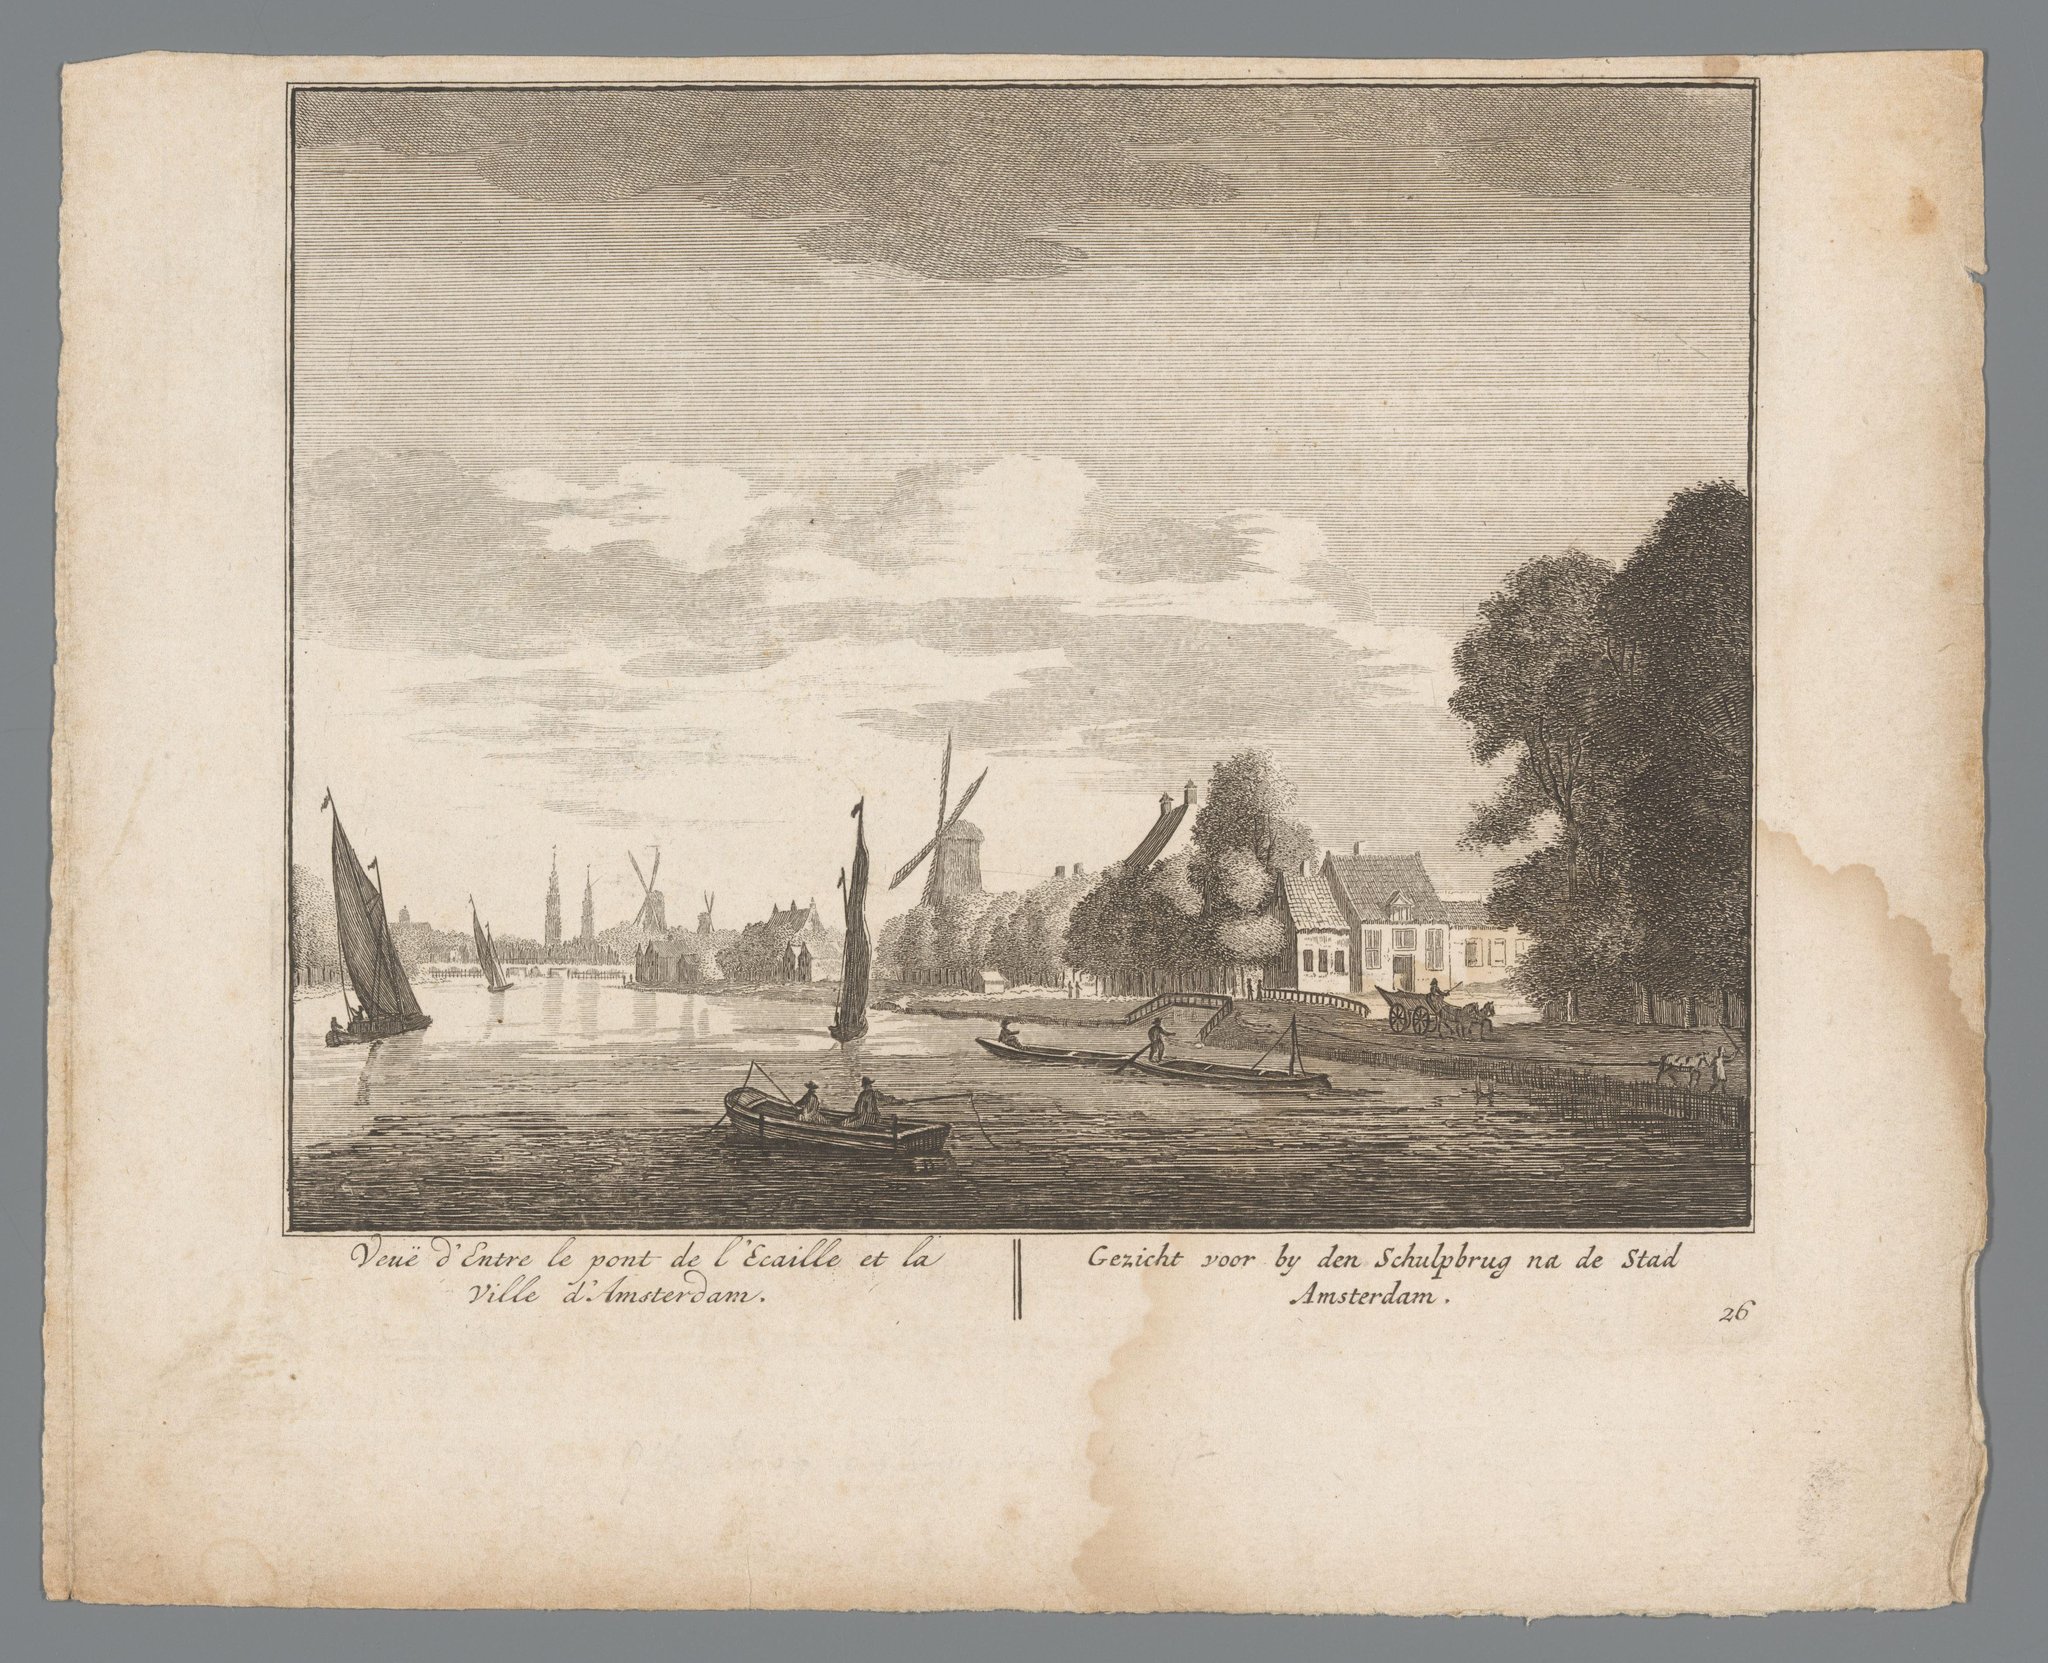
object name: print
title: Veuë d'Entre le pont de l'Escaille et la ville d'Amsterdam / Gezicht voor by den Schulpbrug na de Stad Amsterdam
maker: matthijs pool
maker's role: print maker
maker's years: 1676-1740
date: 1708-1767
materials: paper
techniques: etching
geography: amsterdam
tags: sailing-ship, sailing-boat, river, rowing-boat, canoe, etc., bridge, hotel, hostelry, inn, amsterdam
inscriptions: inscription: ‘52’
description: Prent gebruikt in: Pool, Matthijs. Verscheyde gesigten van de vermaarde rievier de buyten Amstel van de stadt Amsterdam, tot het dorp Ouwerkerk (…) / Plusieurs veuës et perspectives de la fameuse riviére de Buyten-Amstel depuis Amsterdam jusqu'au village d'Ouwerkerk (…). Amsterdam: Matthijs Pool, [1708-1740]. Of in een latere uitgave van deze publicatie, uitgegeven door Leonard Schenk (jaar van uitgave onbekend).